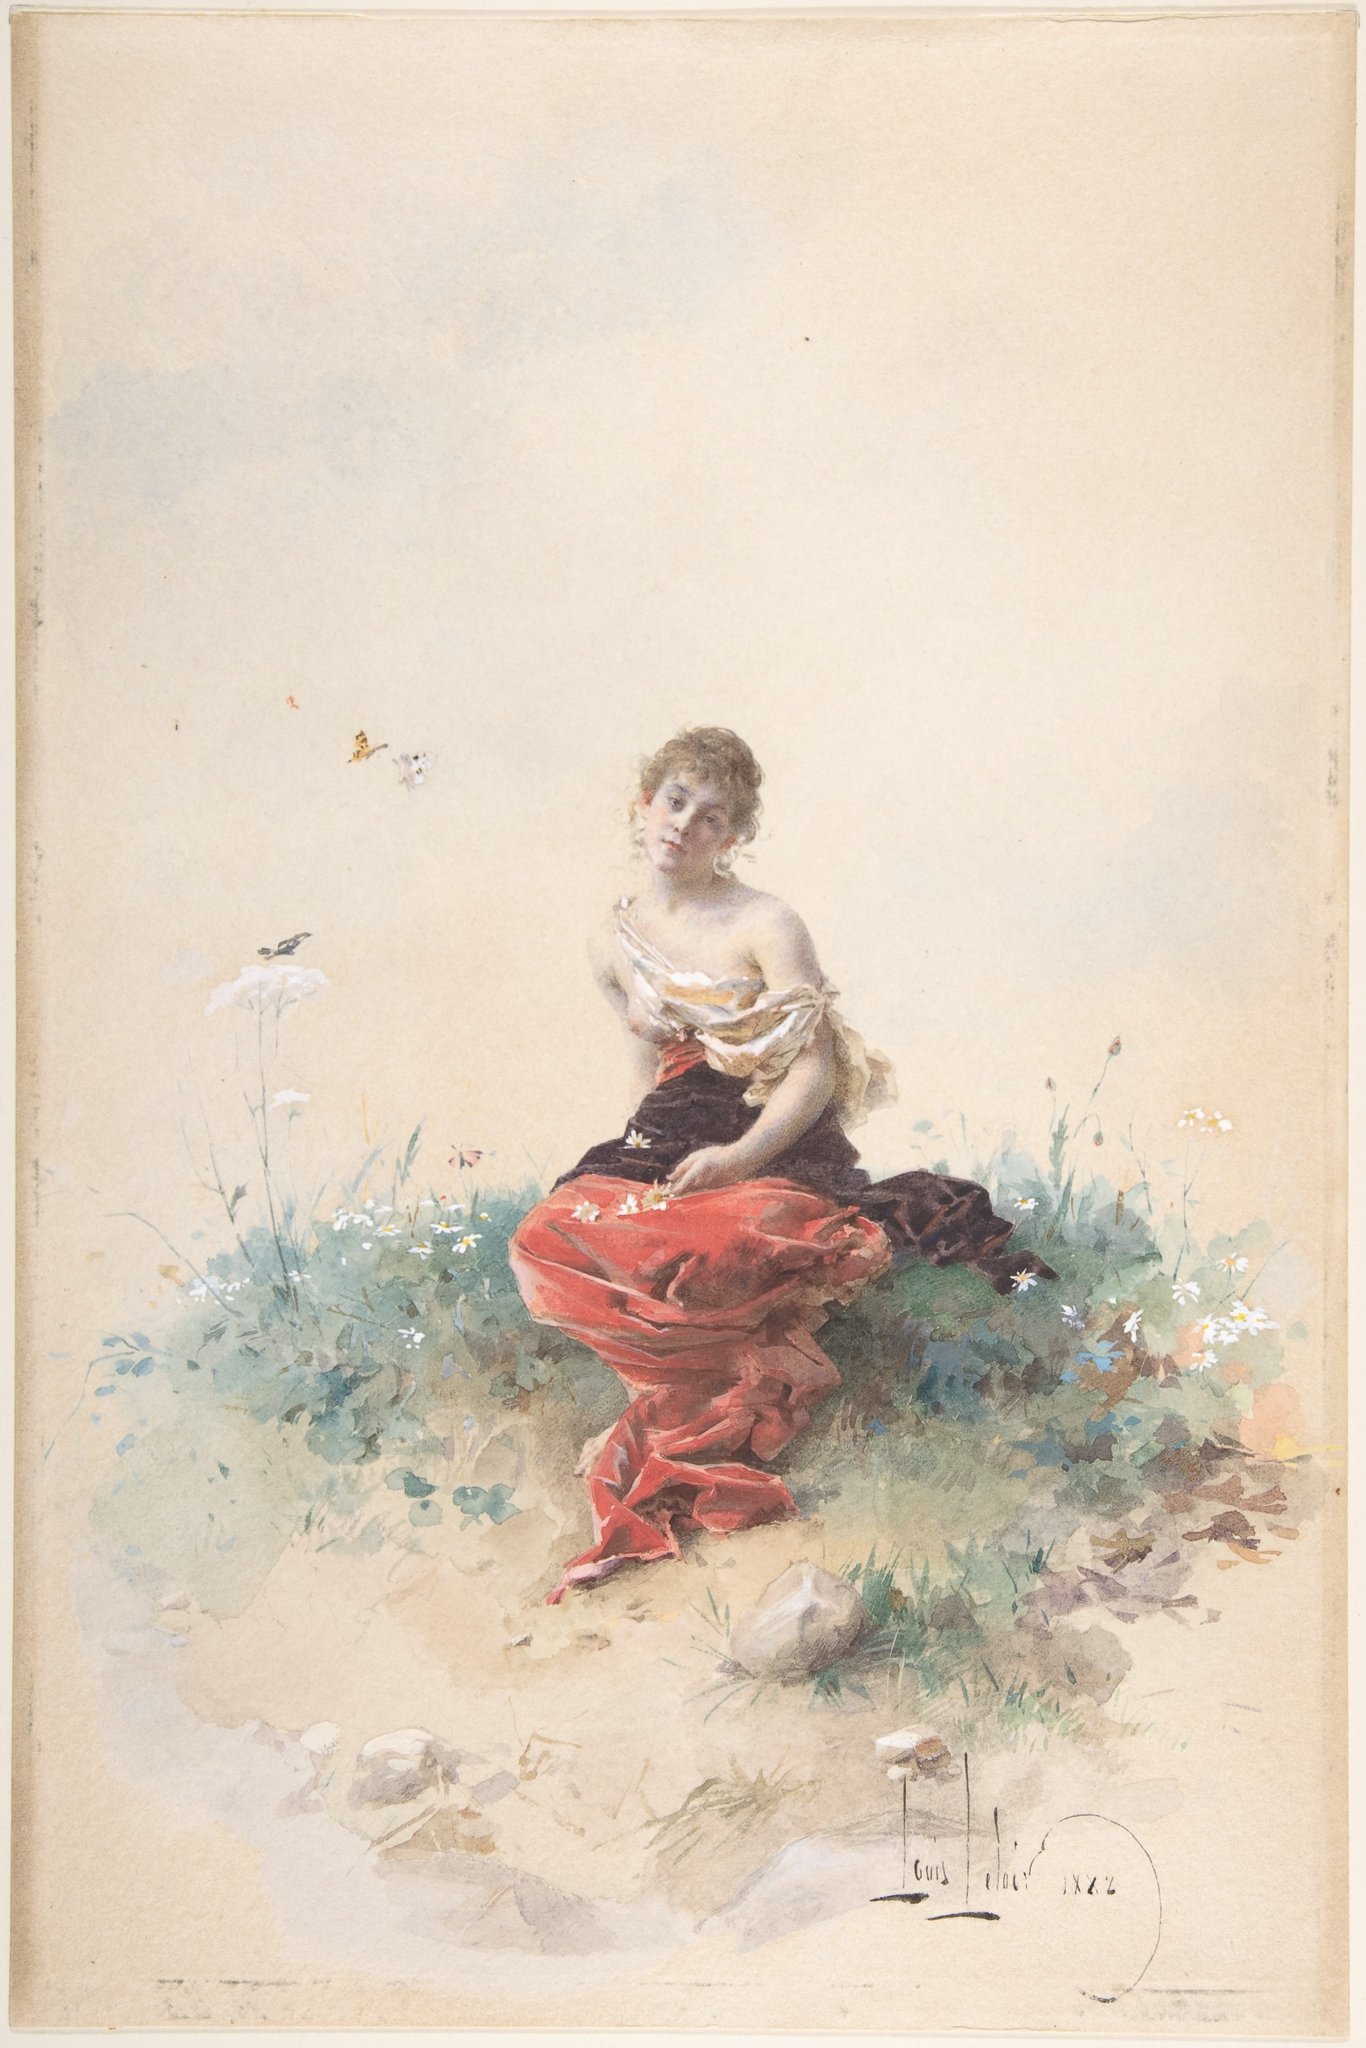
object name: drawing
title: Female Figure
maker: alexandre-louis leloir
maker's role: artist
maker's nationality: french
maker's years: 1843-1884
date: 1801-1900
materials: watercolor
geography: france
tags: women,flowers